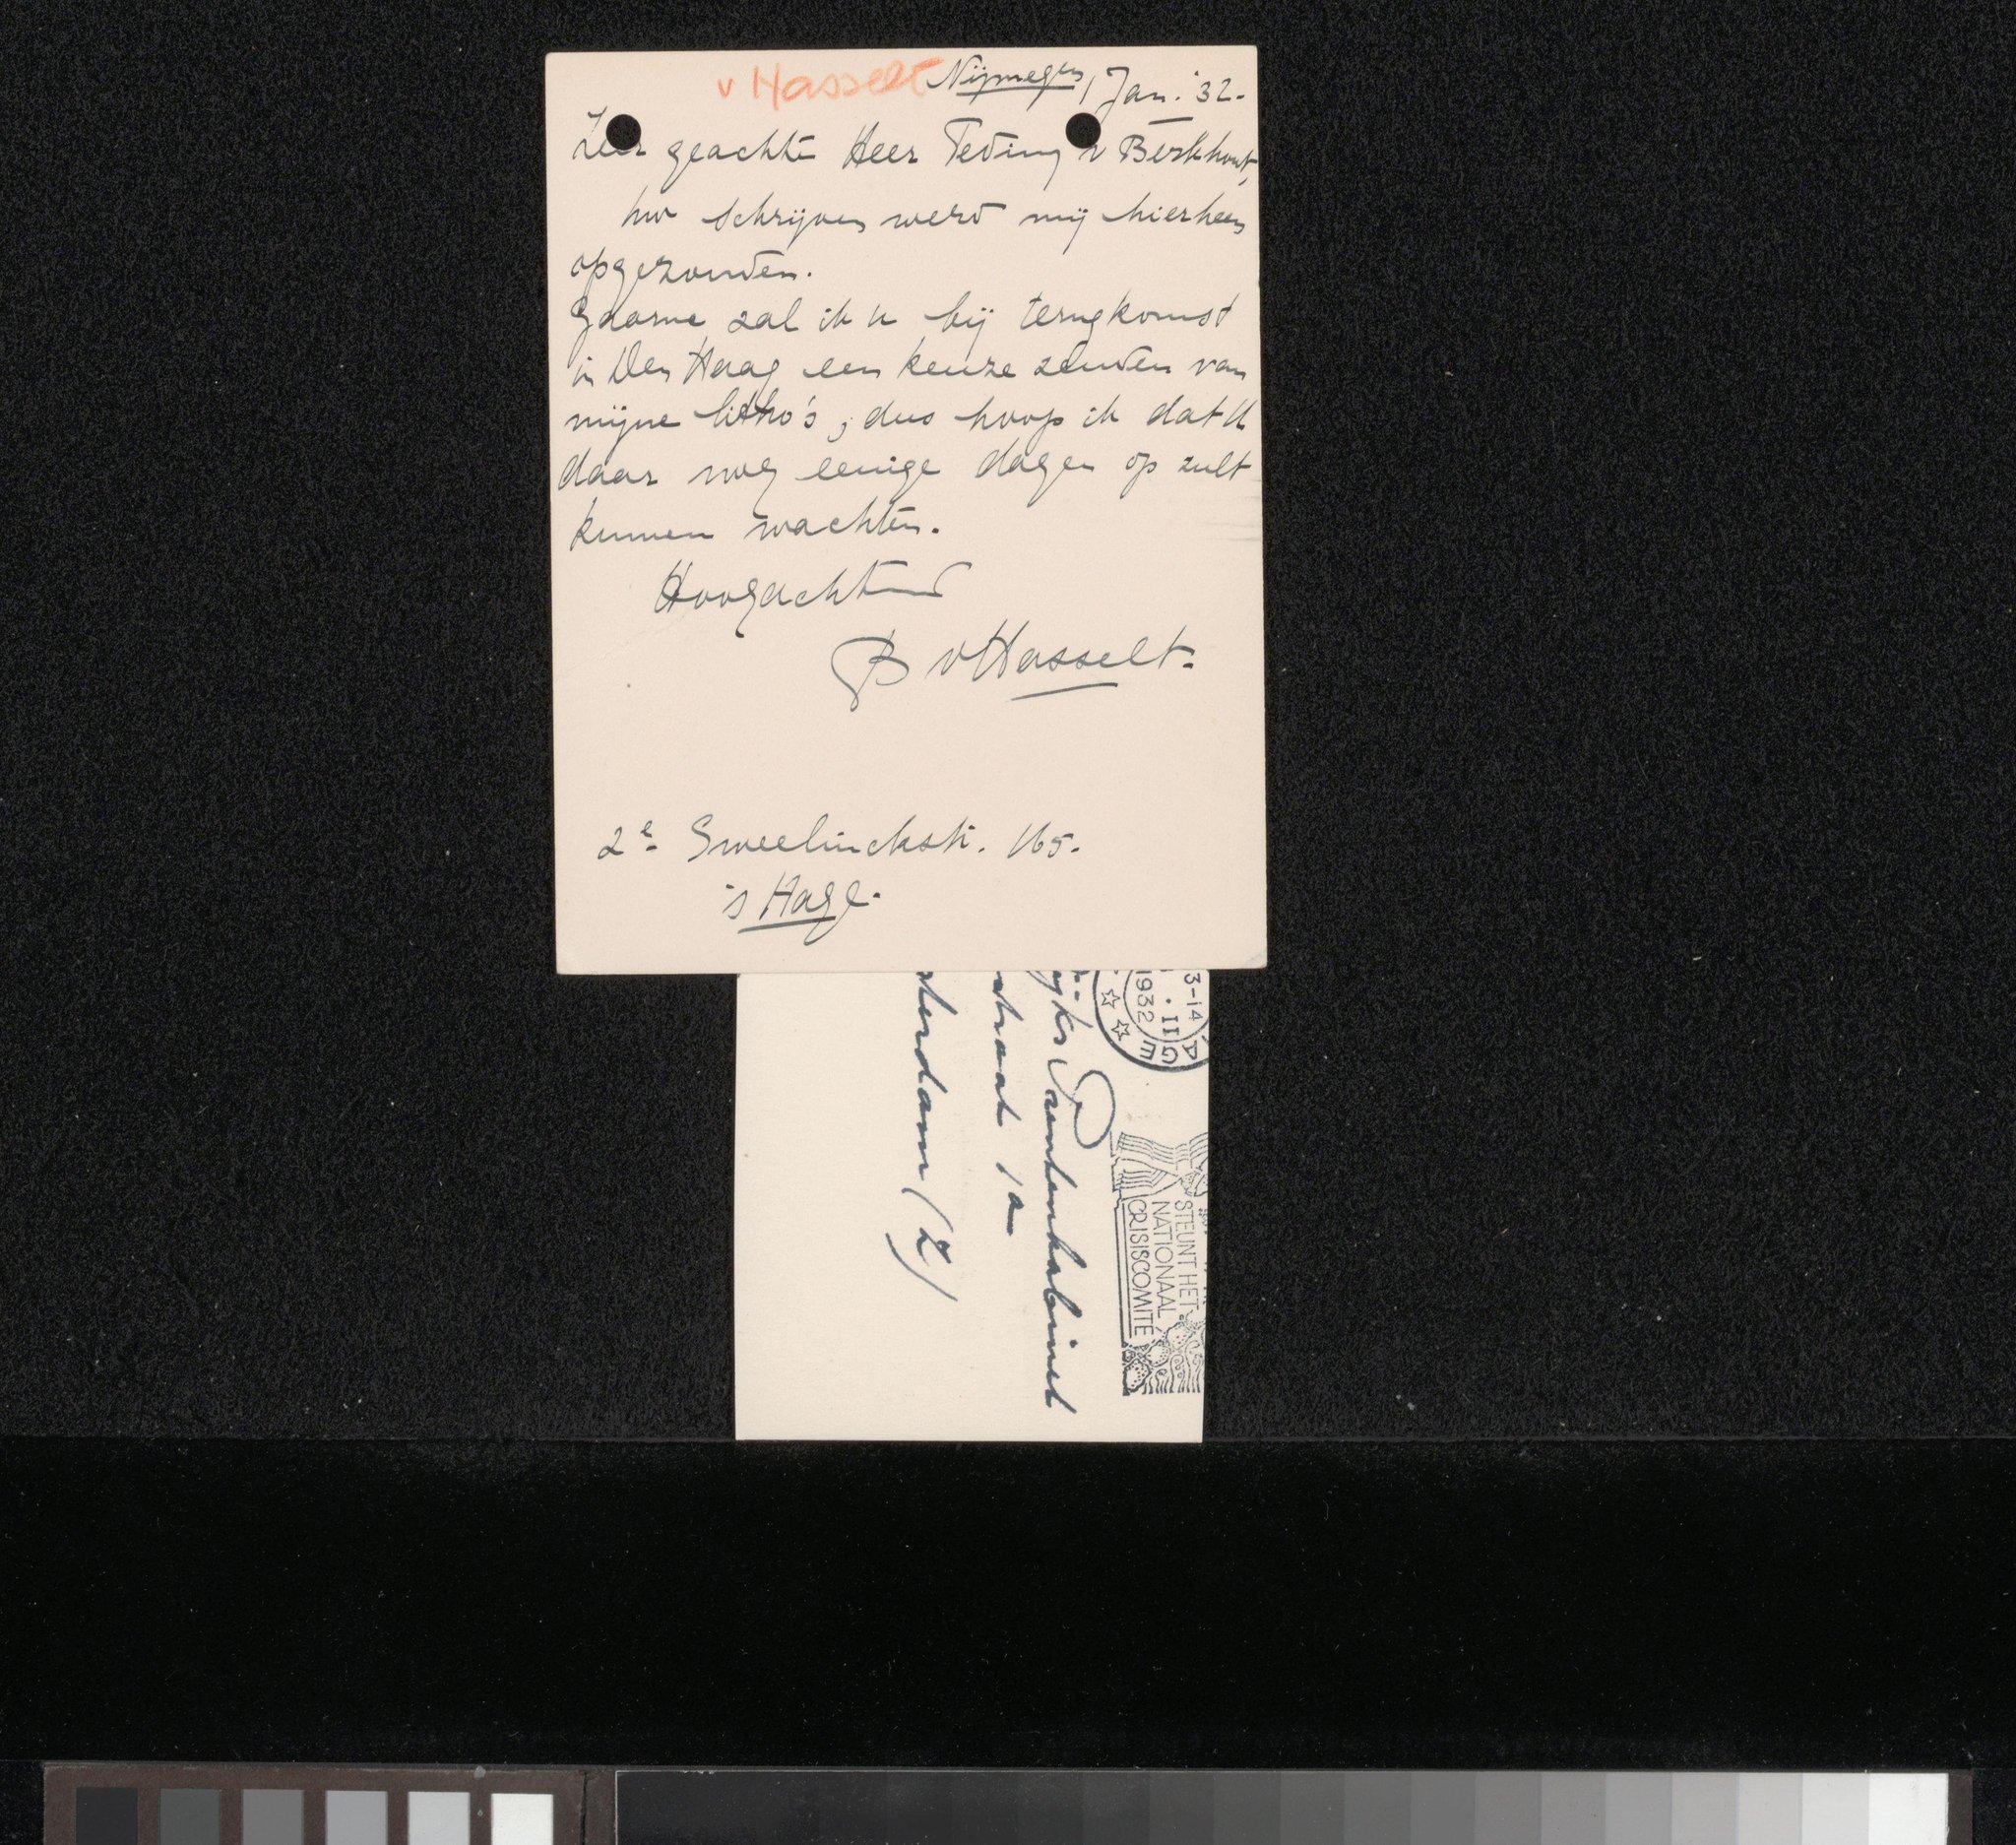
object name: letter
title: Brief aan jonkheer Hendrik Teding van Berkhout (1879-1969)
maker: bertha van hasselt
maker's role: print maker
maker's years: 1878-1932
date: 1932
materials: cardboard, ink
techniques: pen, writing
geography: nijmegen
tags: amsterdam, jonkheer hendrik teding van berkhout (1879-1969), the graphic arts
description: Brief bevat briefkaart betreffende teruggezonden werken.